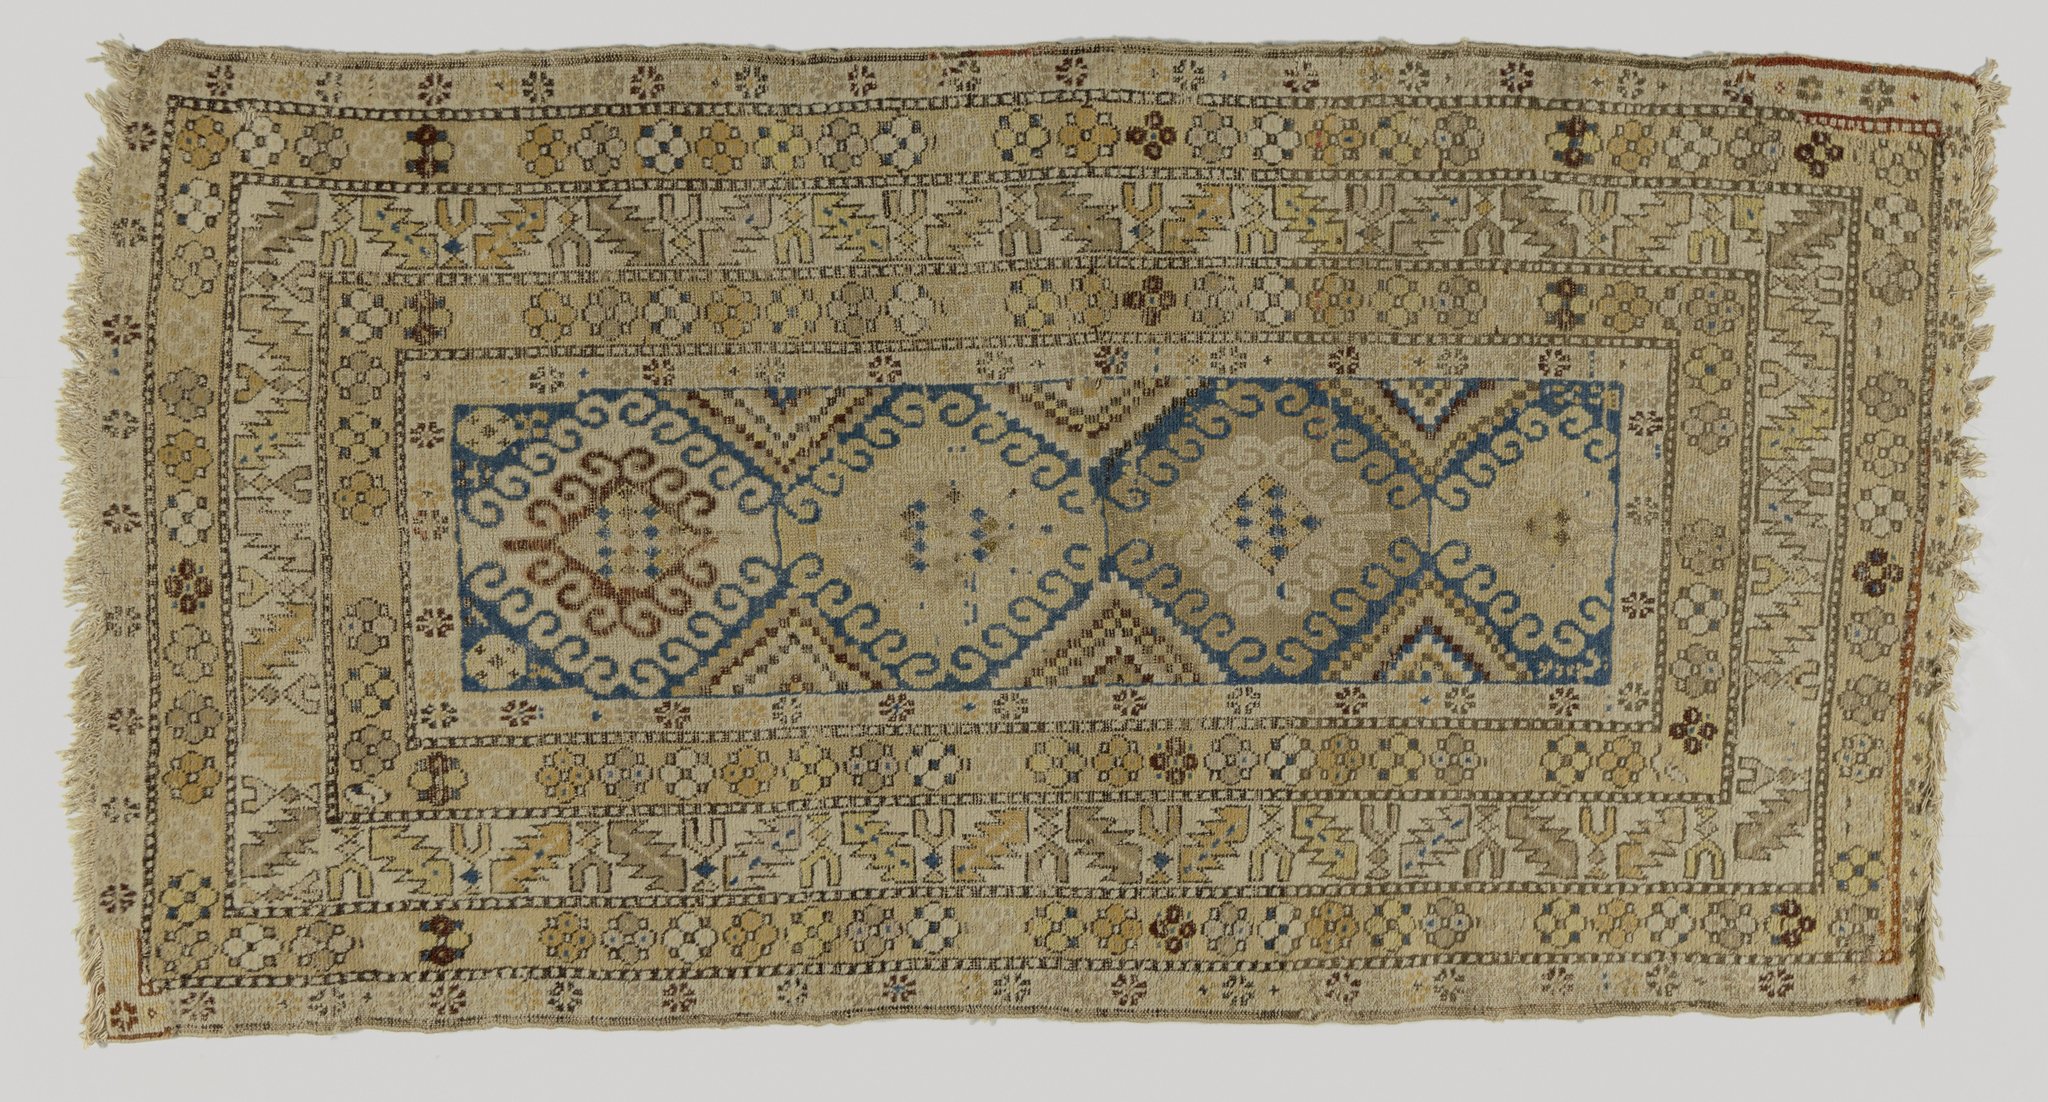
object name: kleed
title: Zeshoekenkleed, DAGHESTAN of SHIRWAN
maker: Anonymous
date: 1800-1900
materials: wool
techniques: ghiordes knot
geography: shirvan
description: Zeshoekenkleed, Daghestan of Shirwan. Middenveld: kobaltblauw fond met vier zeshoeken in naturel, blond en beige met haakmotieven als omtrekken. Terzijden halve driehoeken met trapgevelomtrekken. Rand: vijfvoudig. De middelste is wit met z.g. wijnglasmotief (= hoekige tulp) in beige tinten met zwarte contouren. Hier buiten een paar gelijke zomen in geel met rozetten. Een tweede paar zomen in naturel met rozetten.